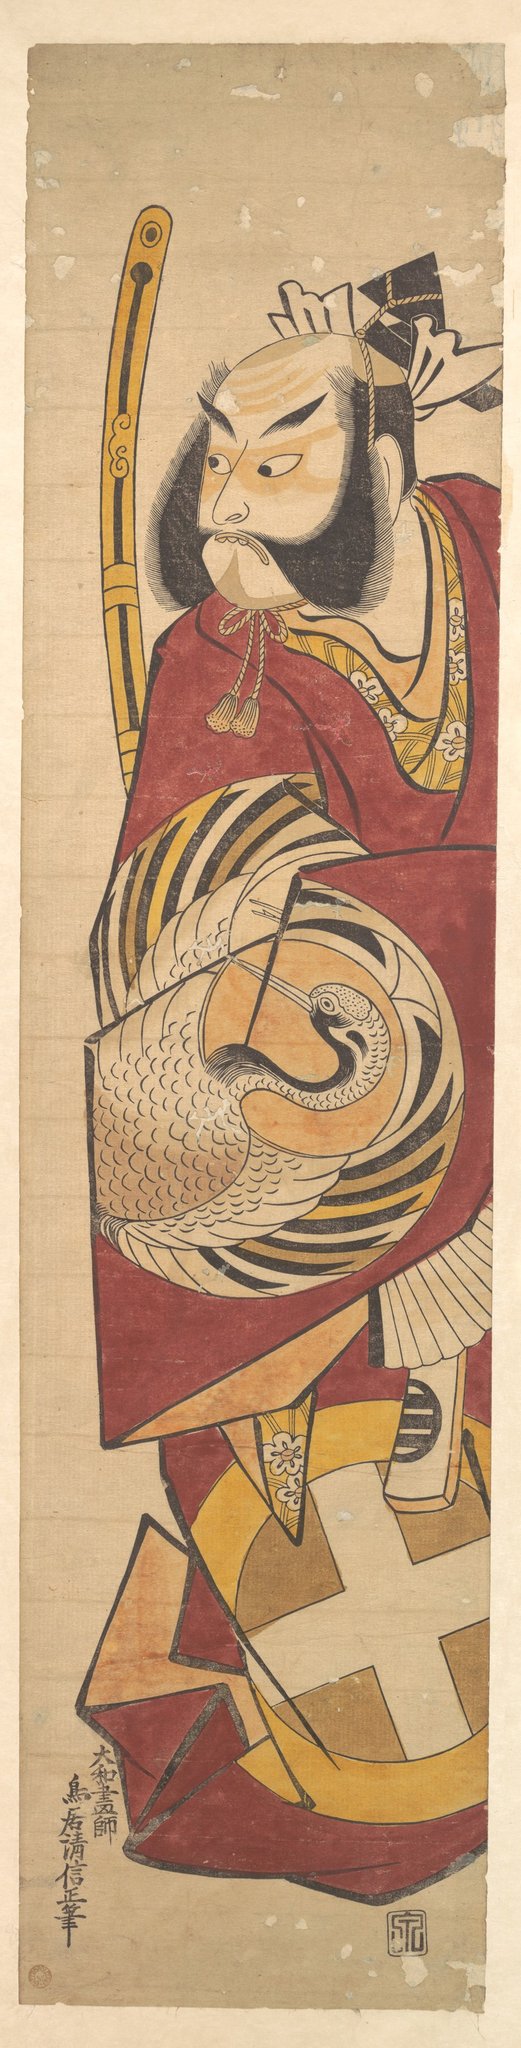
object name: print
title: The Actor Bandō Hikosaburō 1st (?)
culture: japanese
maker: torii kiyonobu i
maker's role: artist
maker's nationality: japanese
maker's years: 1664-1729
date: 1725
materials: ink, paper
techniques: woodblock print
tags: men,actors